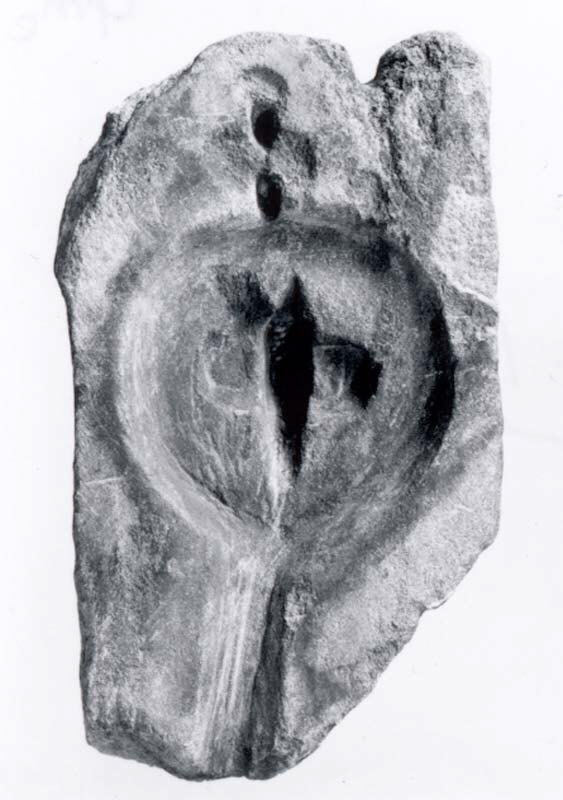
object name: mold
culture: iranian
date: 900-801 BCE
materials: stone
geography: iran